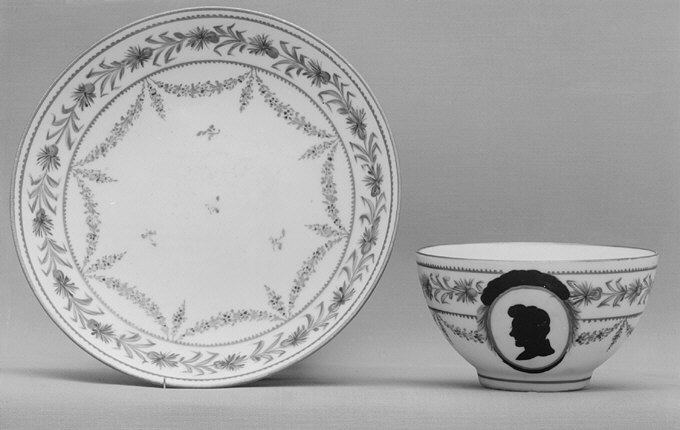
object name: teabowl and saucer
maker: nyon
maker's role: factory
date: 1785-1800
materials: hard paste porcelain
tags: human figures,profiles